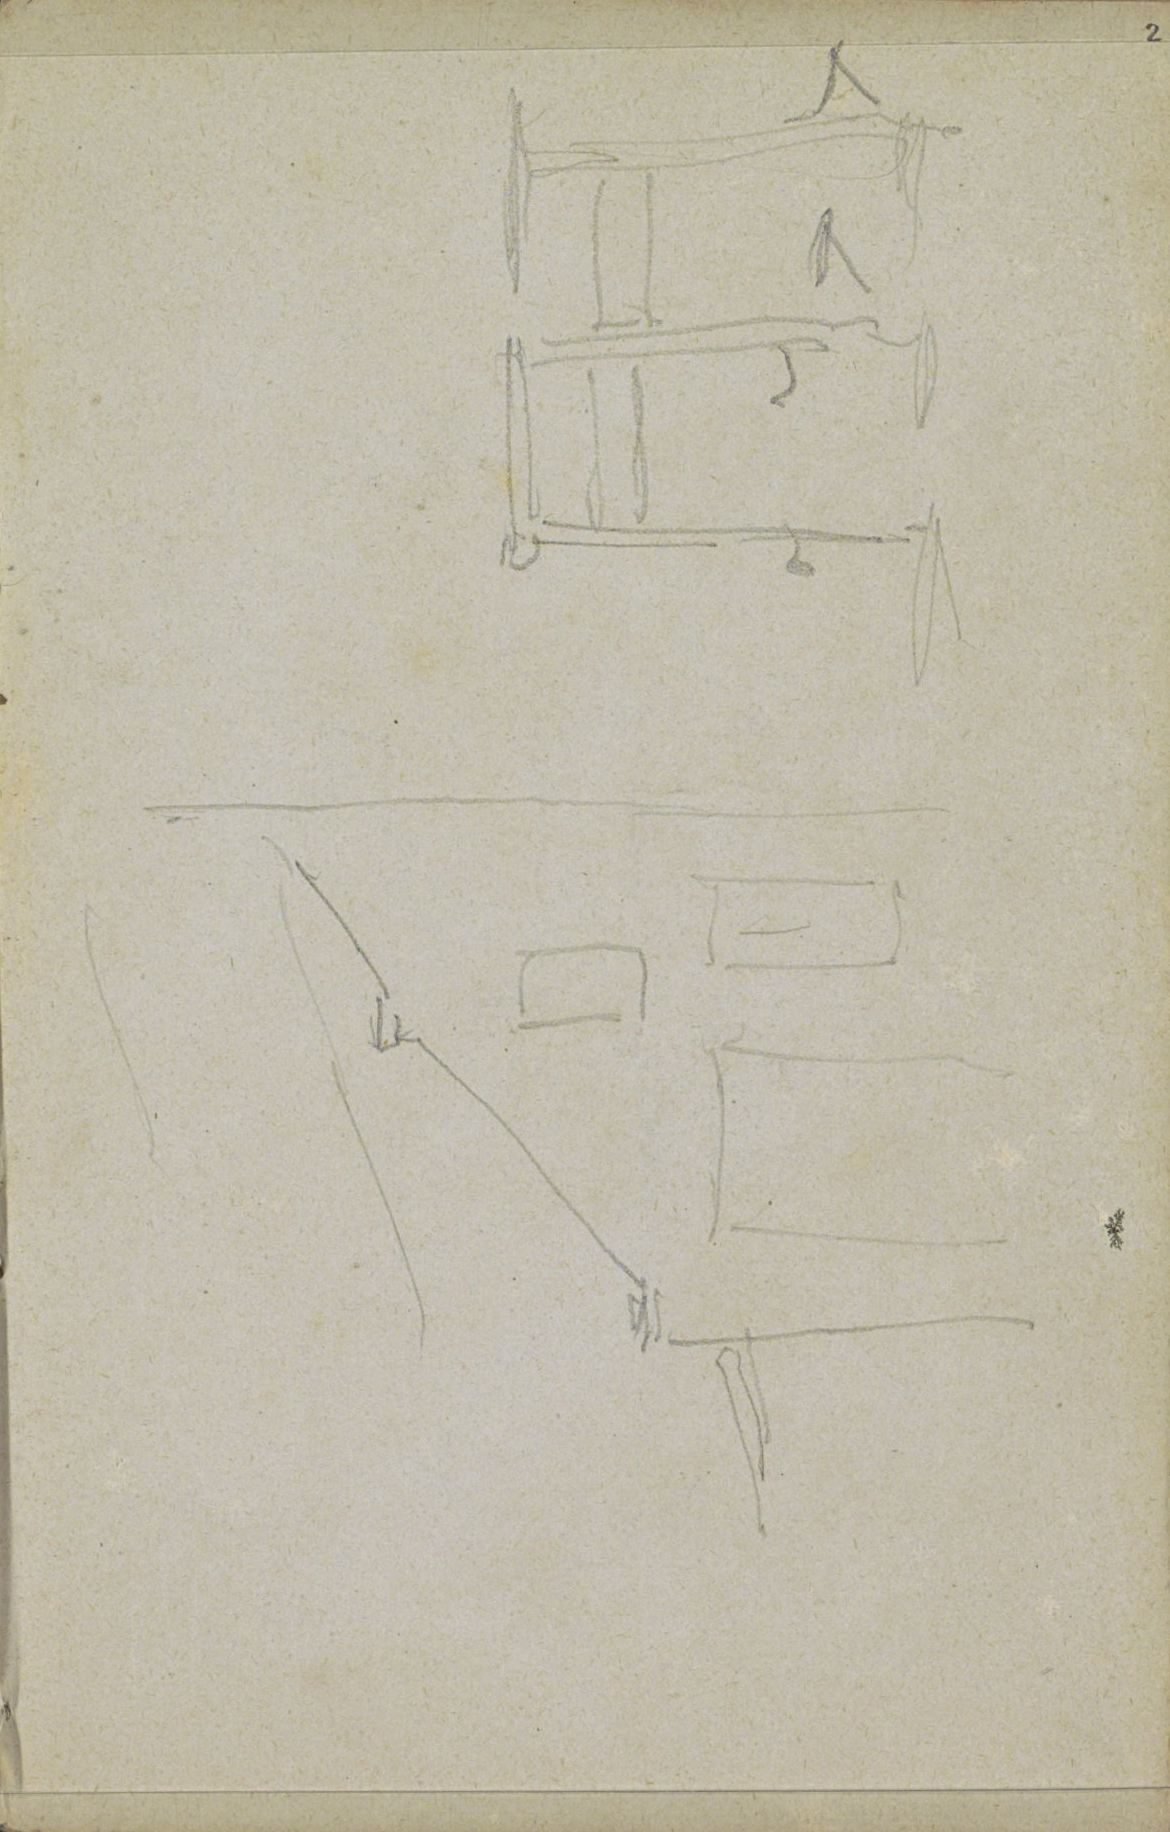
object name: sketchbook leaf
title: Architectuurstudies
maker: adrianus eversen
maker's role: draughtsman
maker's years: 1818-1897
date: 1828-1897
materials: paper, pencil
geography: netherlands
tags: architectural detail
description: Architectuurstudies. Blad 2 recto uit een schetsboek met 58 bladen.